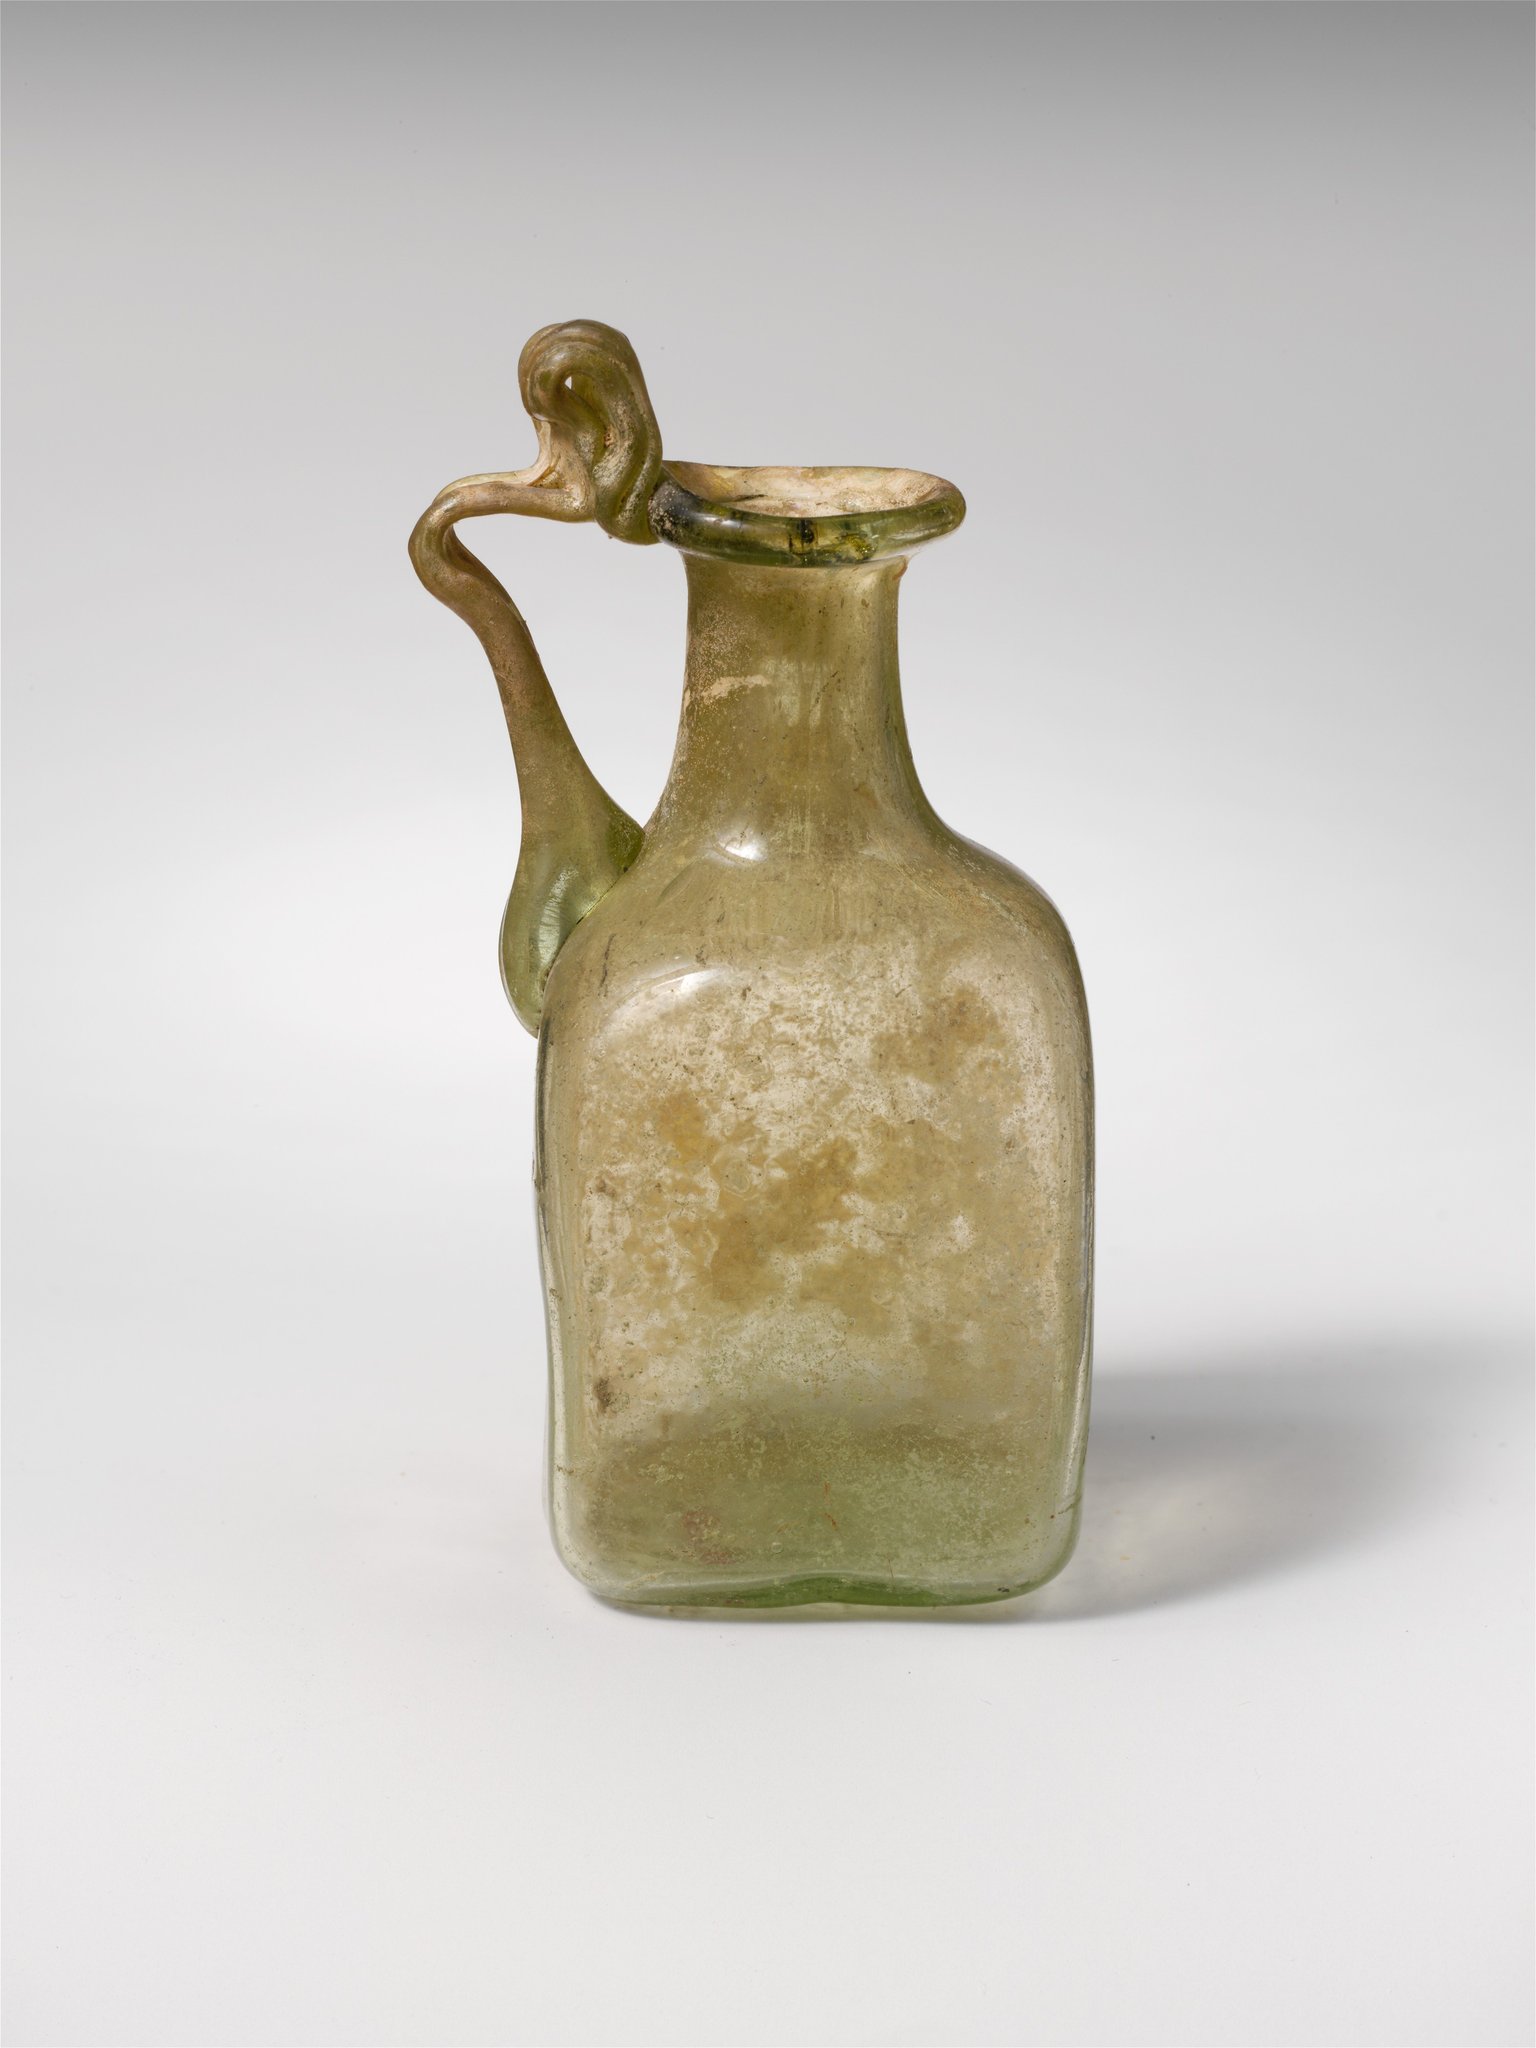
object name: bottle, two handled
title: Glass bottle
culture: roman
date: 1-300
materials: glass